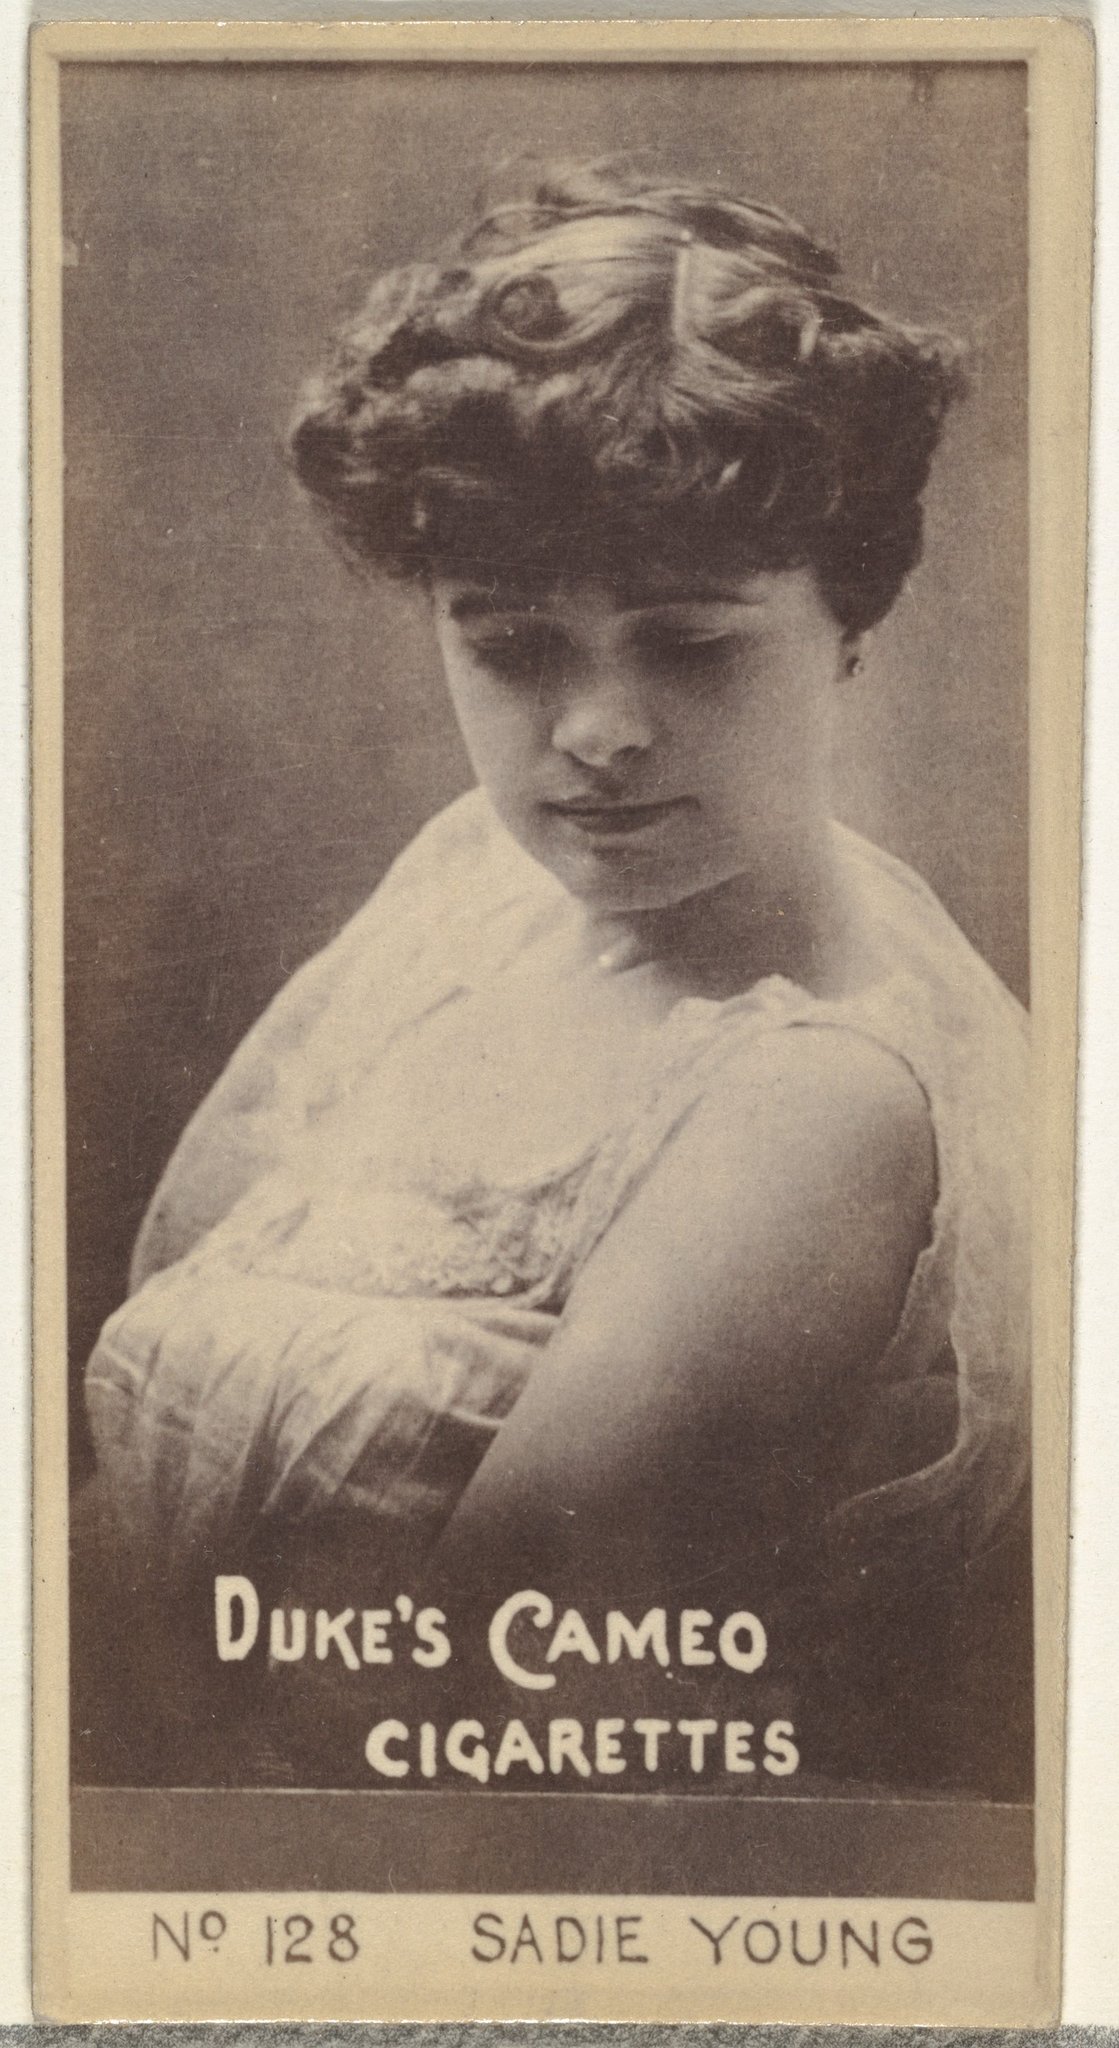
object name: photograph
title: Card Number 128, Sadie Young, from the Actors and Actresses series (N145-4) issued by Duke Sons & Co. to promote Cameo Cigarettes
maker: w. duke, sons & co.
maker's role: publisher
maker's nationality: american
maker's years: 1870-1920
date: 1880-1889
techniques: albumen silver print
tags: portraits,women,actresses